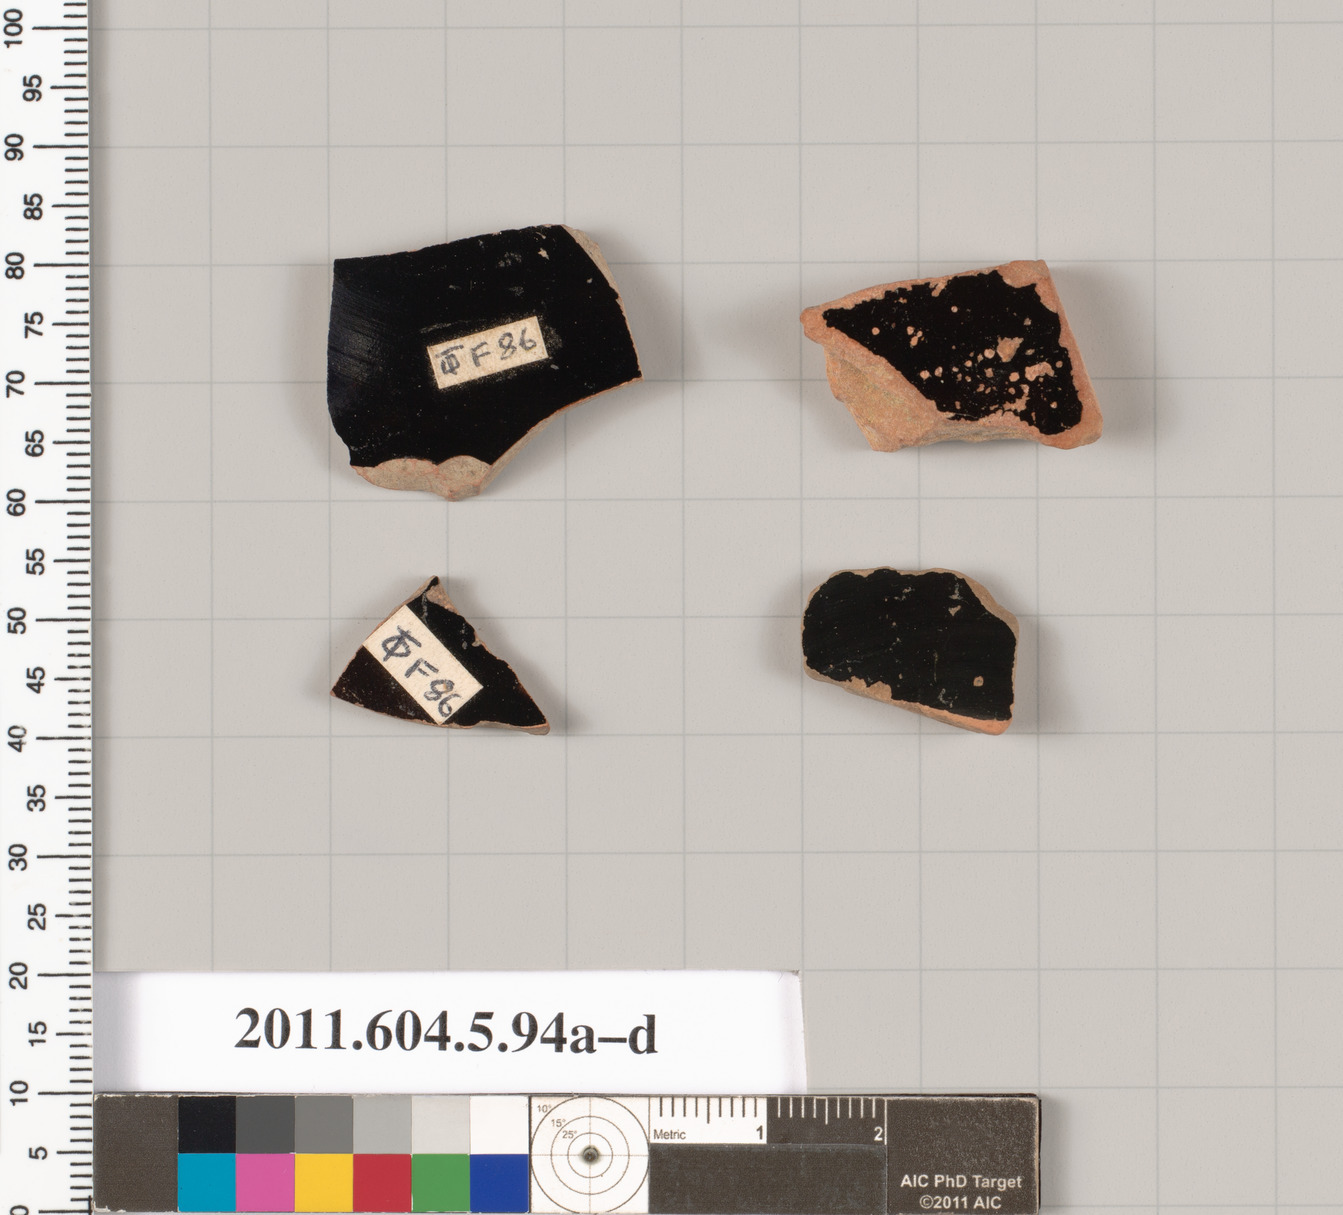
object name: kylix fragment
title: Terracotta fragments of kylikes (drinking cups)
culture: greek, attic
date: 475-451 BCE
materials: terracotta